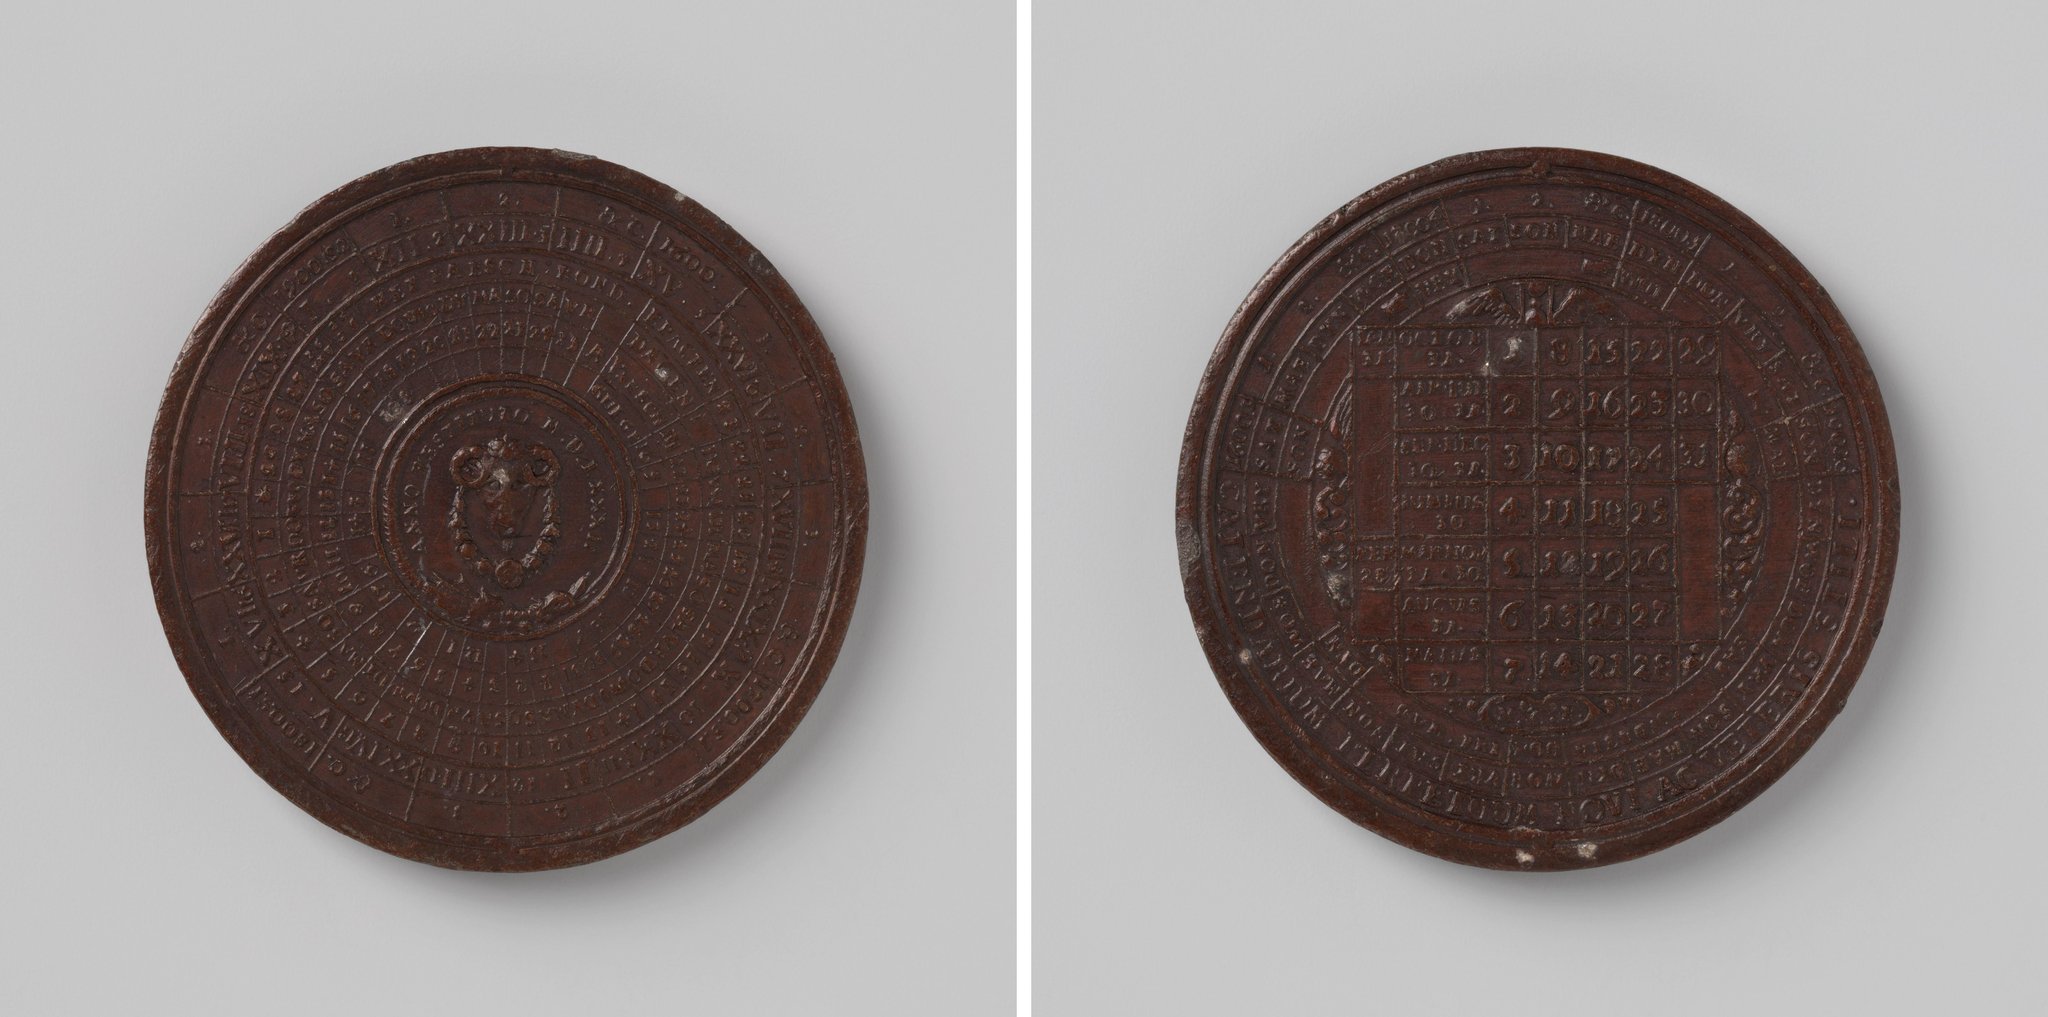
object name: history medal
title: Paus Gregorius XIII, op de invoering van de nieuwe tijdrekening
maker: nicolas chevalier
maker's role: print maker, publisher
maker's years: 1661-1720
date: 1694-1720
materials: bronze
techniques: striking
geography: netherlands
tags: rome, gregorius xiii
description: Bronzen penning. Voorzijde: ramskop binnen omschrift en slang die in zijn eigen staart bijt; daaromheen zes cirkels met dagen van maand. Keerzijde: tabel, daaromheen drie cirkels met dagen van maand e.d.